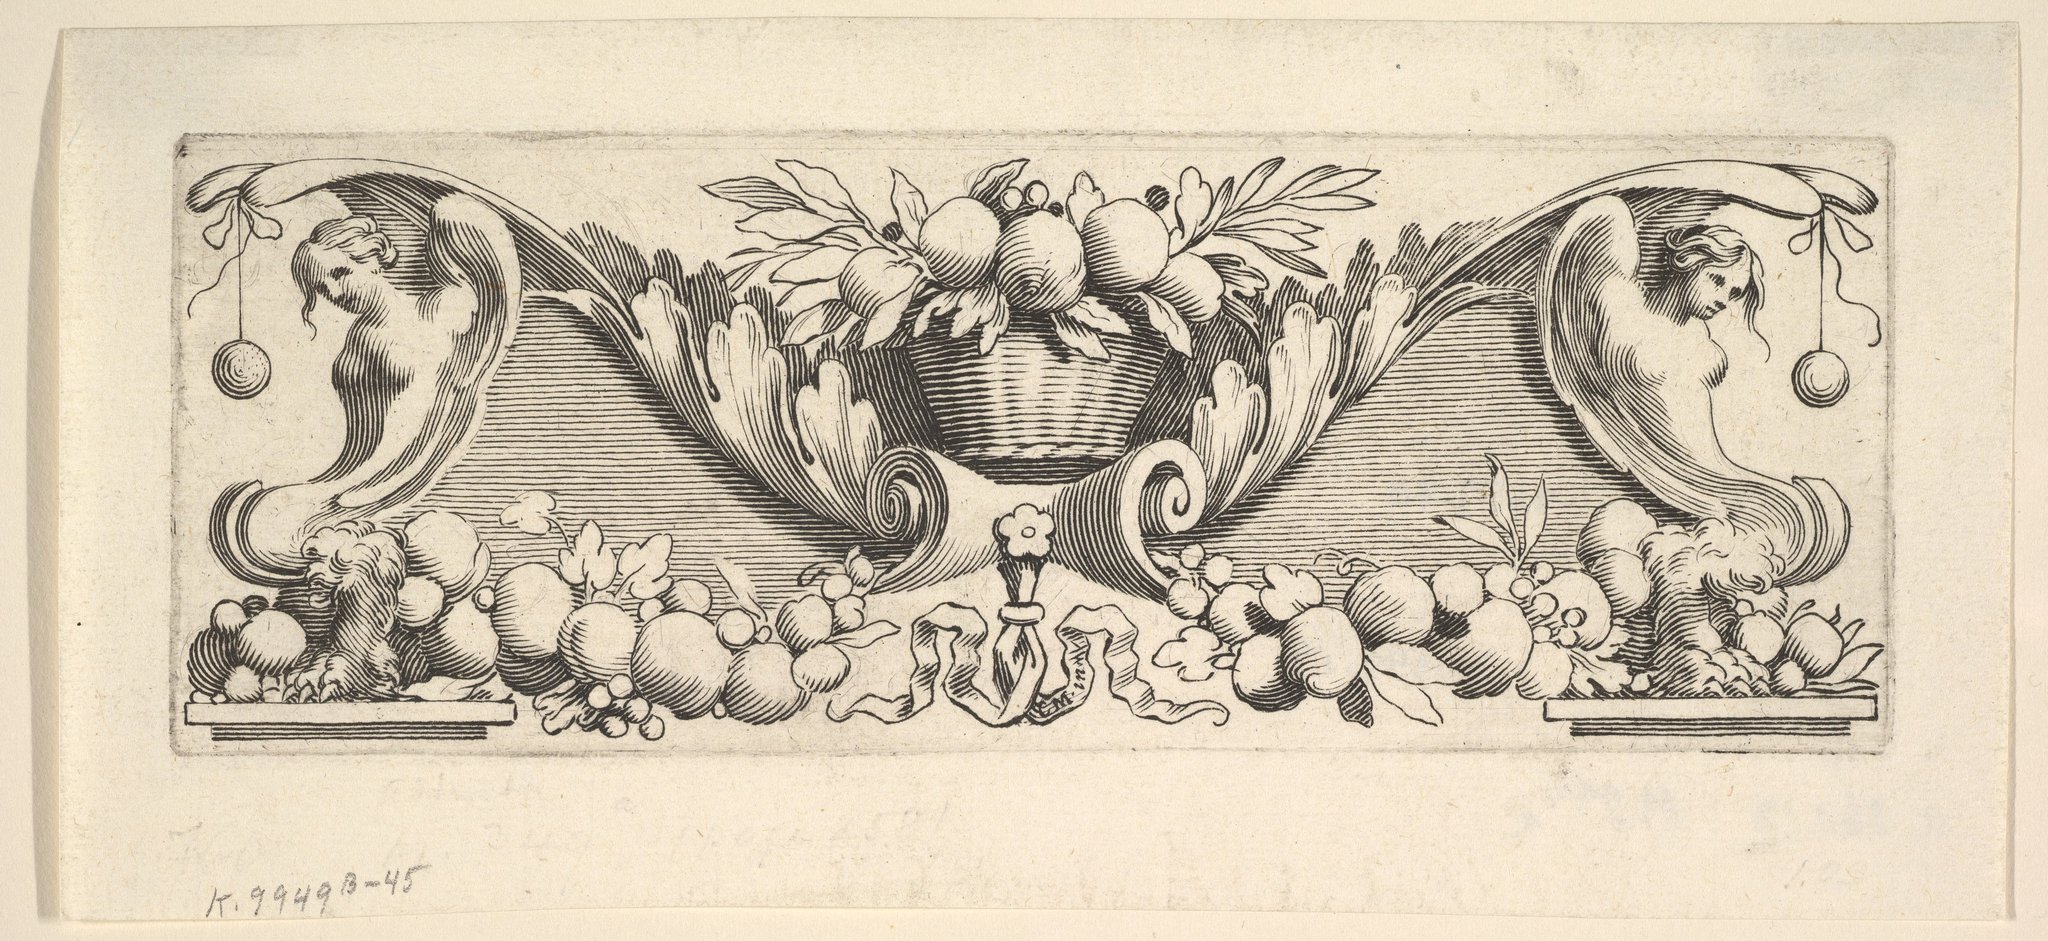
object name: print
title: Headband: Basket of Fruit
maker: claude mellan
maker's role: artist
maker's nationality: french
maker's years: 1598-1688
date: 1600-1688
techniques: engraving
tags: fruit